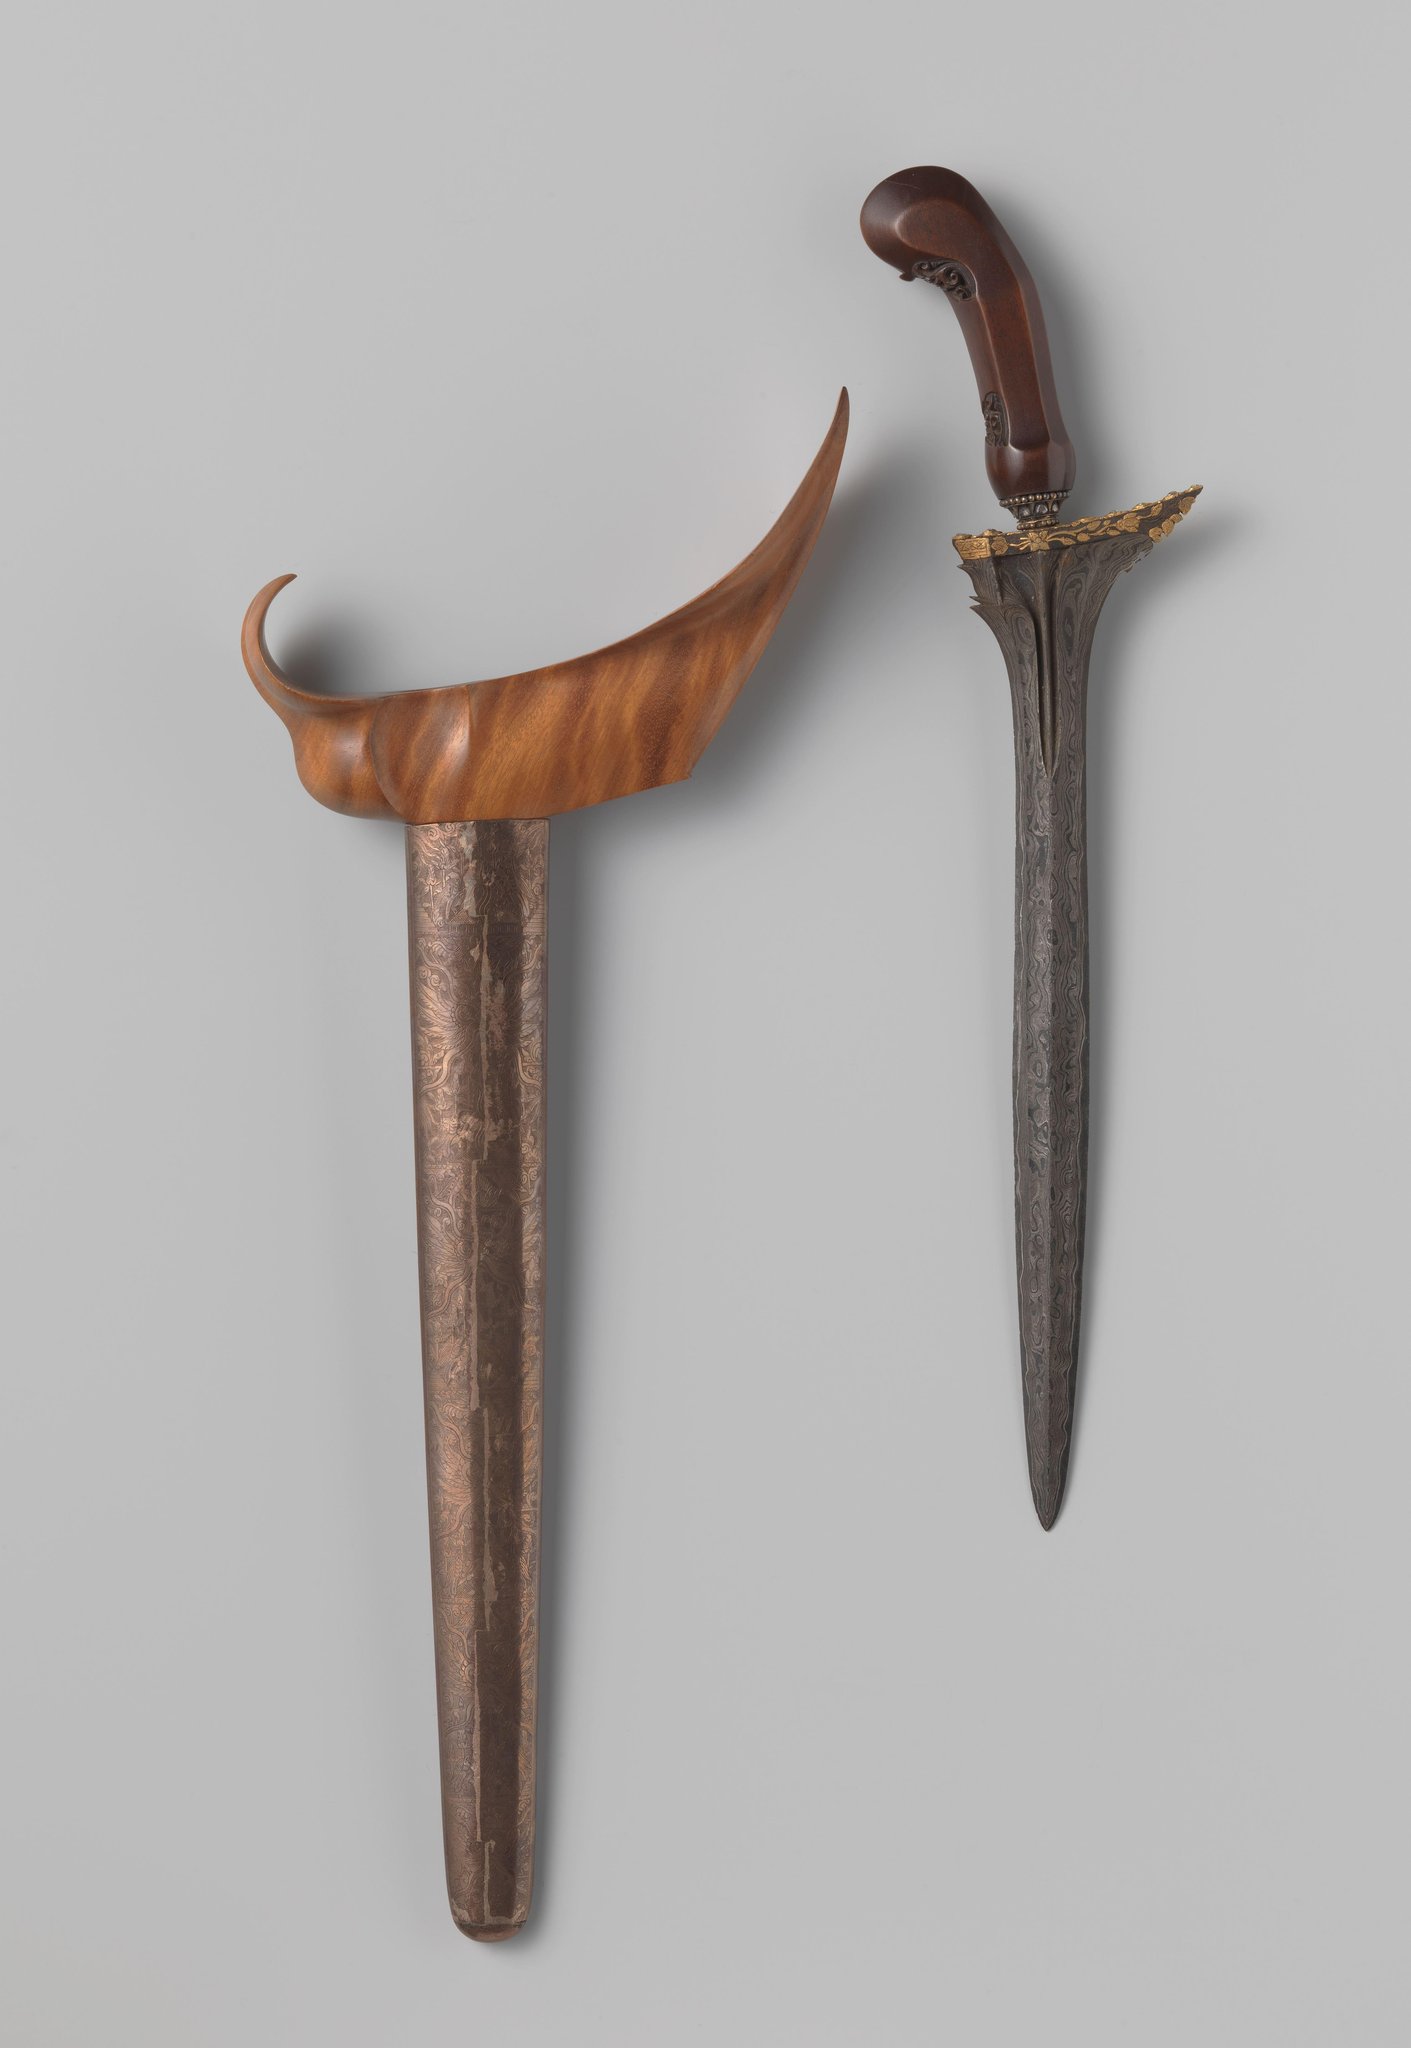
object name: kris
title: Javaanse kris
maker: Anonymous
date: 1500-1900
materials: diamond, iron, nickel, gold alloy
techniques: pamo technique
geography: java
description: Kris, lemmet in pamor-techniek,de ganja met goud geïncrusteerd voorzover het de zijvlakken betreft (floralistisch ornament), op bovenvlak zeven diamantjes.